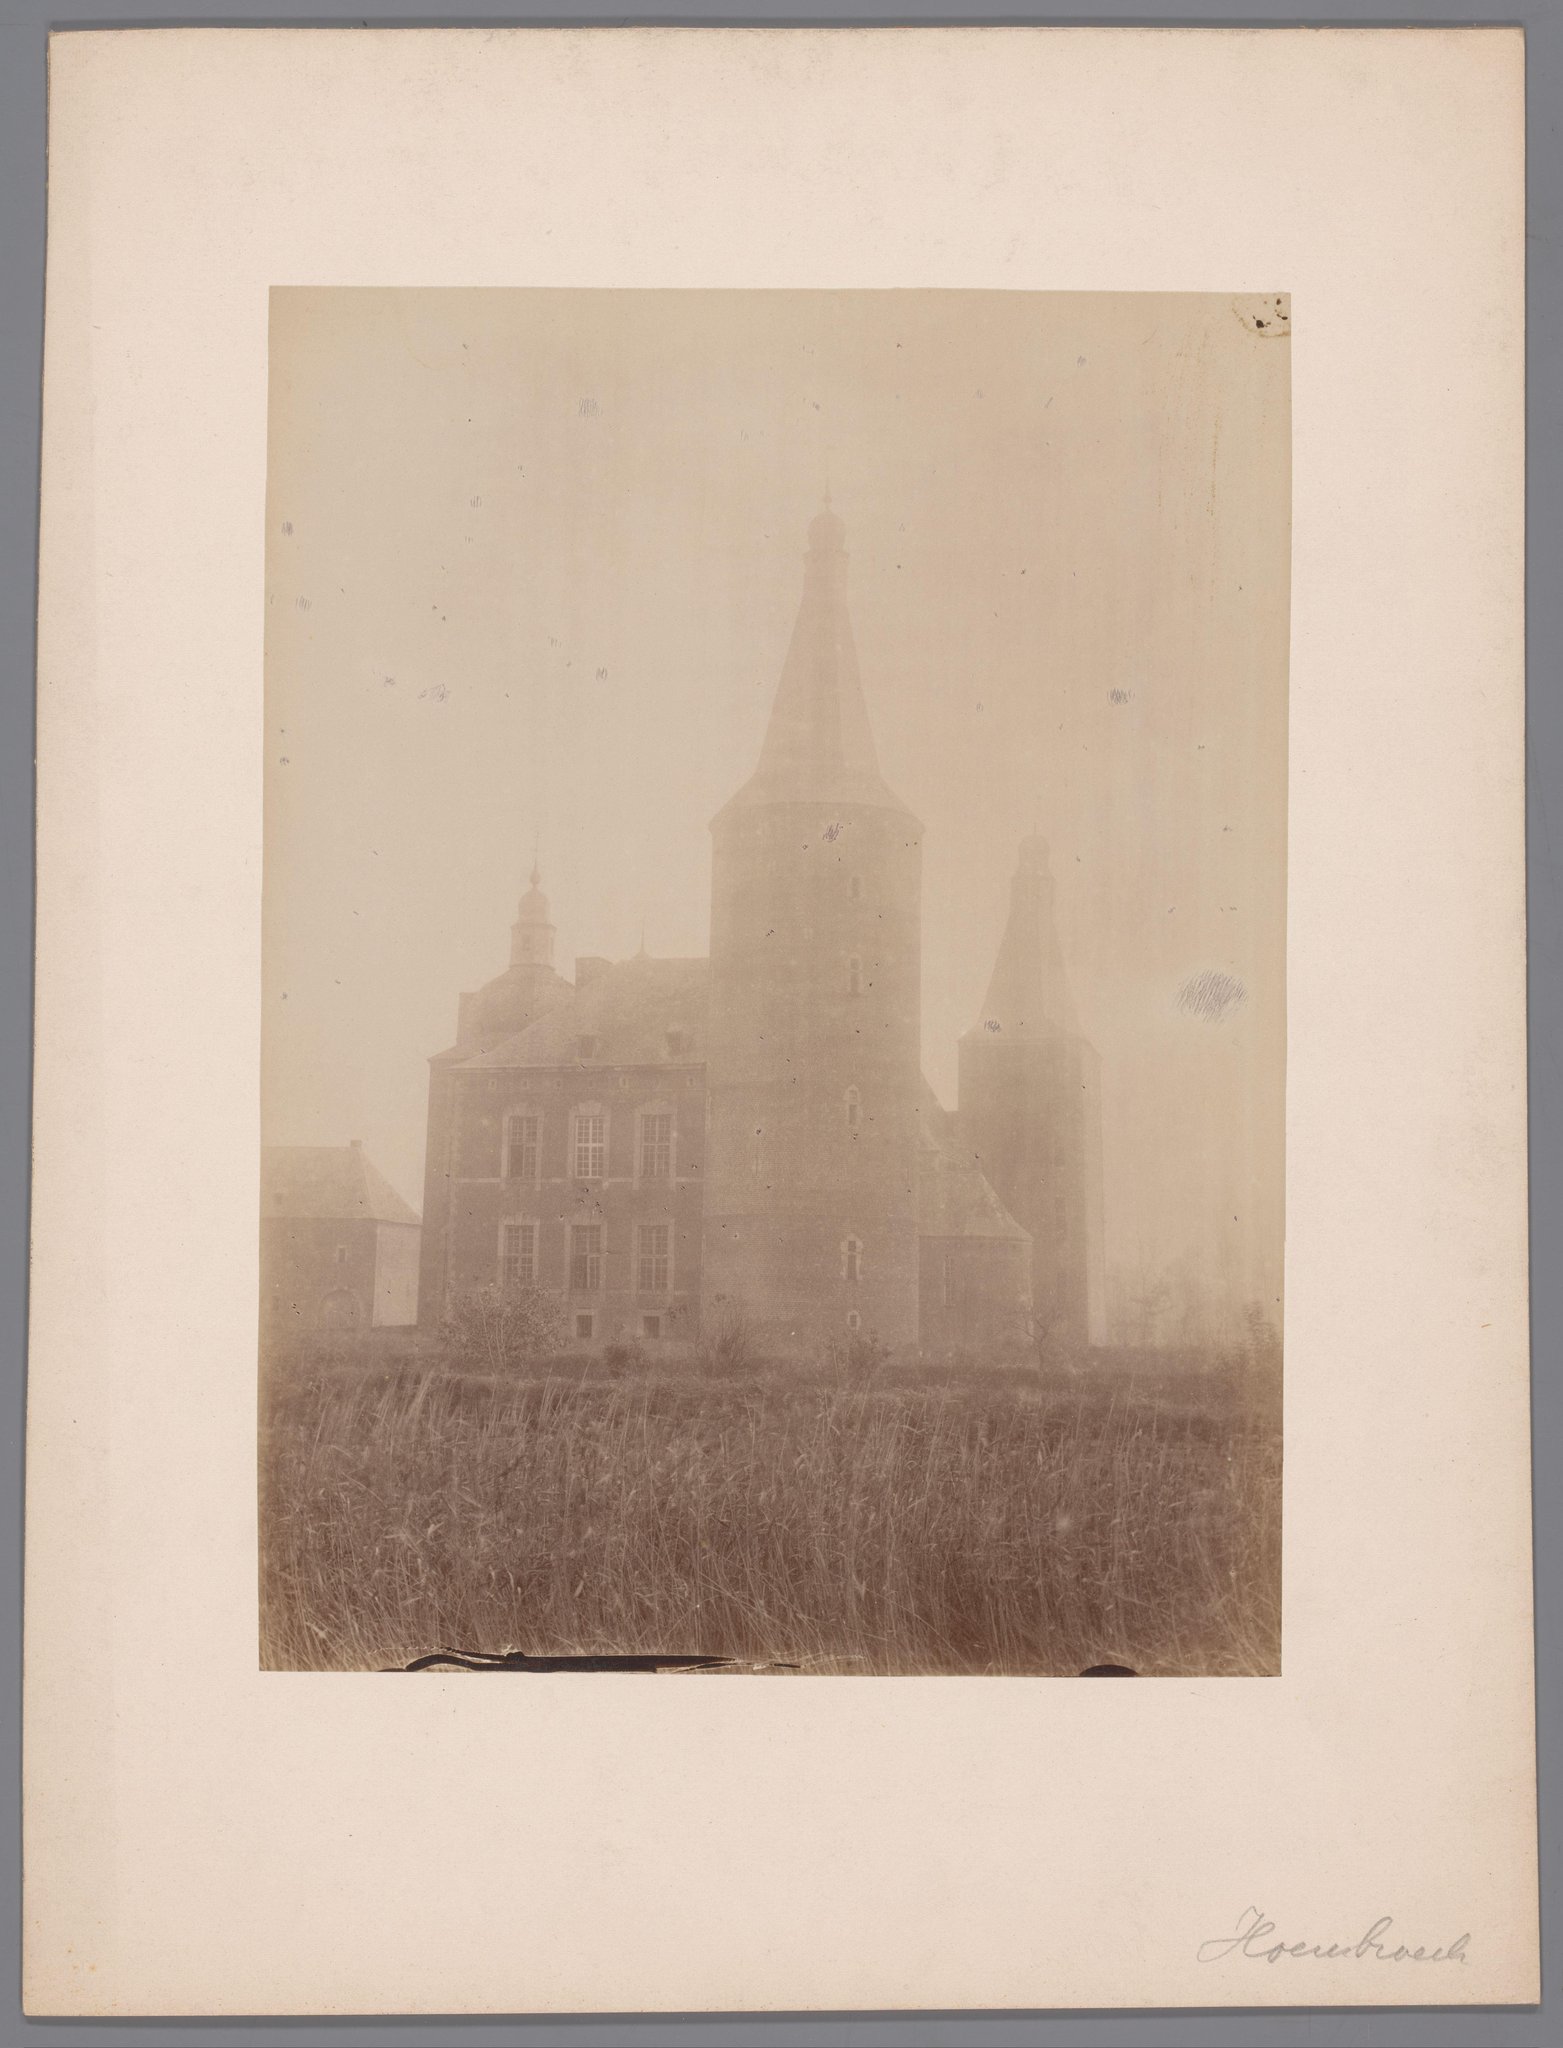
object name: photograph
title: Westzijde van Kasteel Hoensbroek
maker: anoniem (monumentenzorg)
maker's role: fotograaf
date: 1903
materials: cardboard, photographic support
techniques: collodion silver print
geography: hoensbroek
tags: castle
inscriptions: annotation: ‘Hoensbroek’, annotation: ‘Hoensbroek (L.)/ kasteel/ nov 1903’